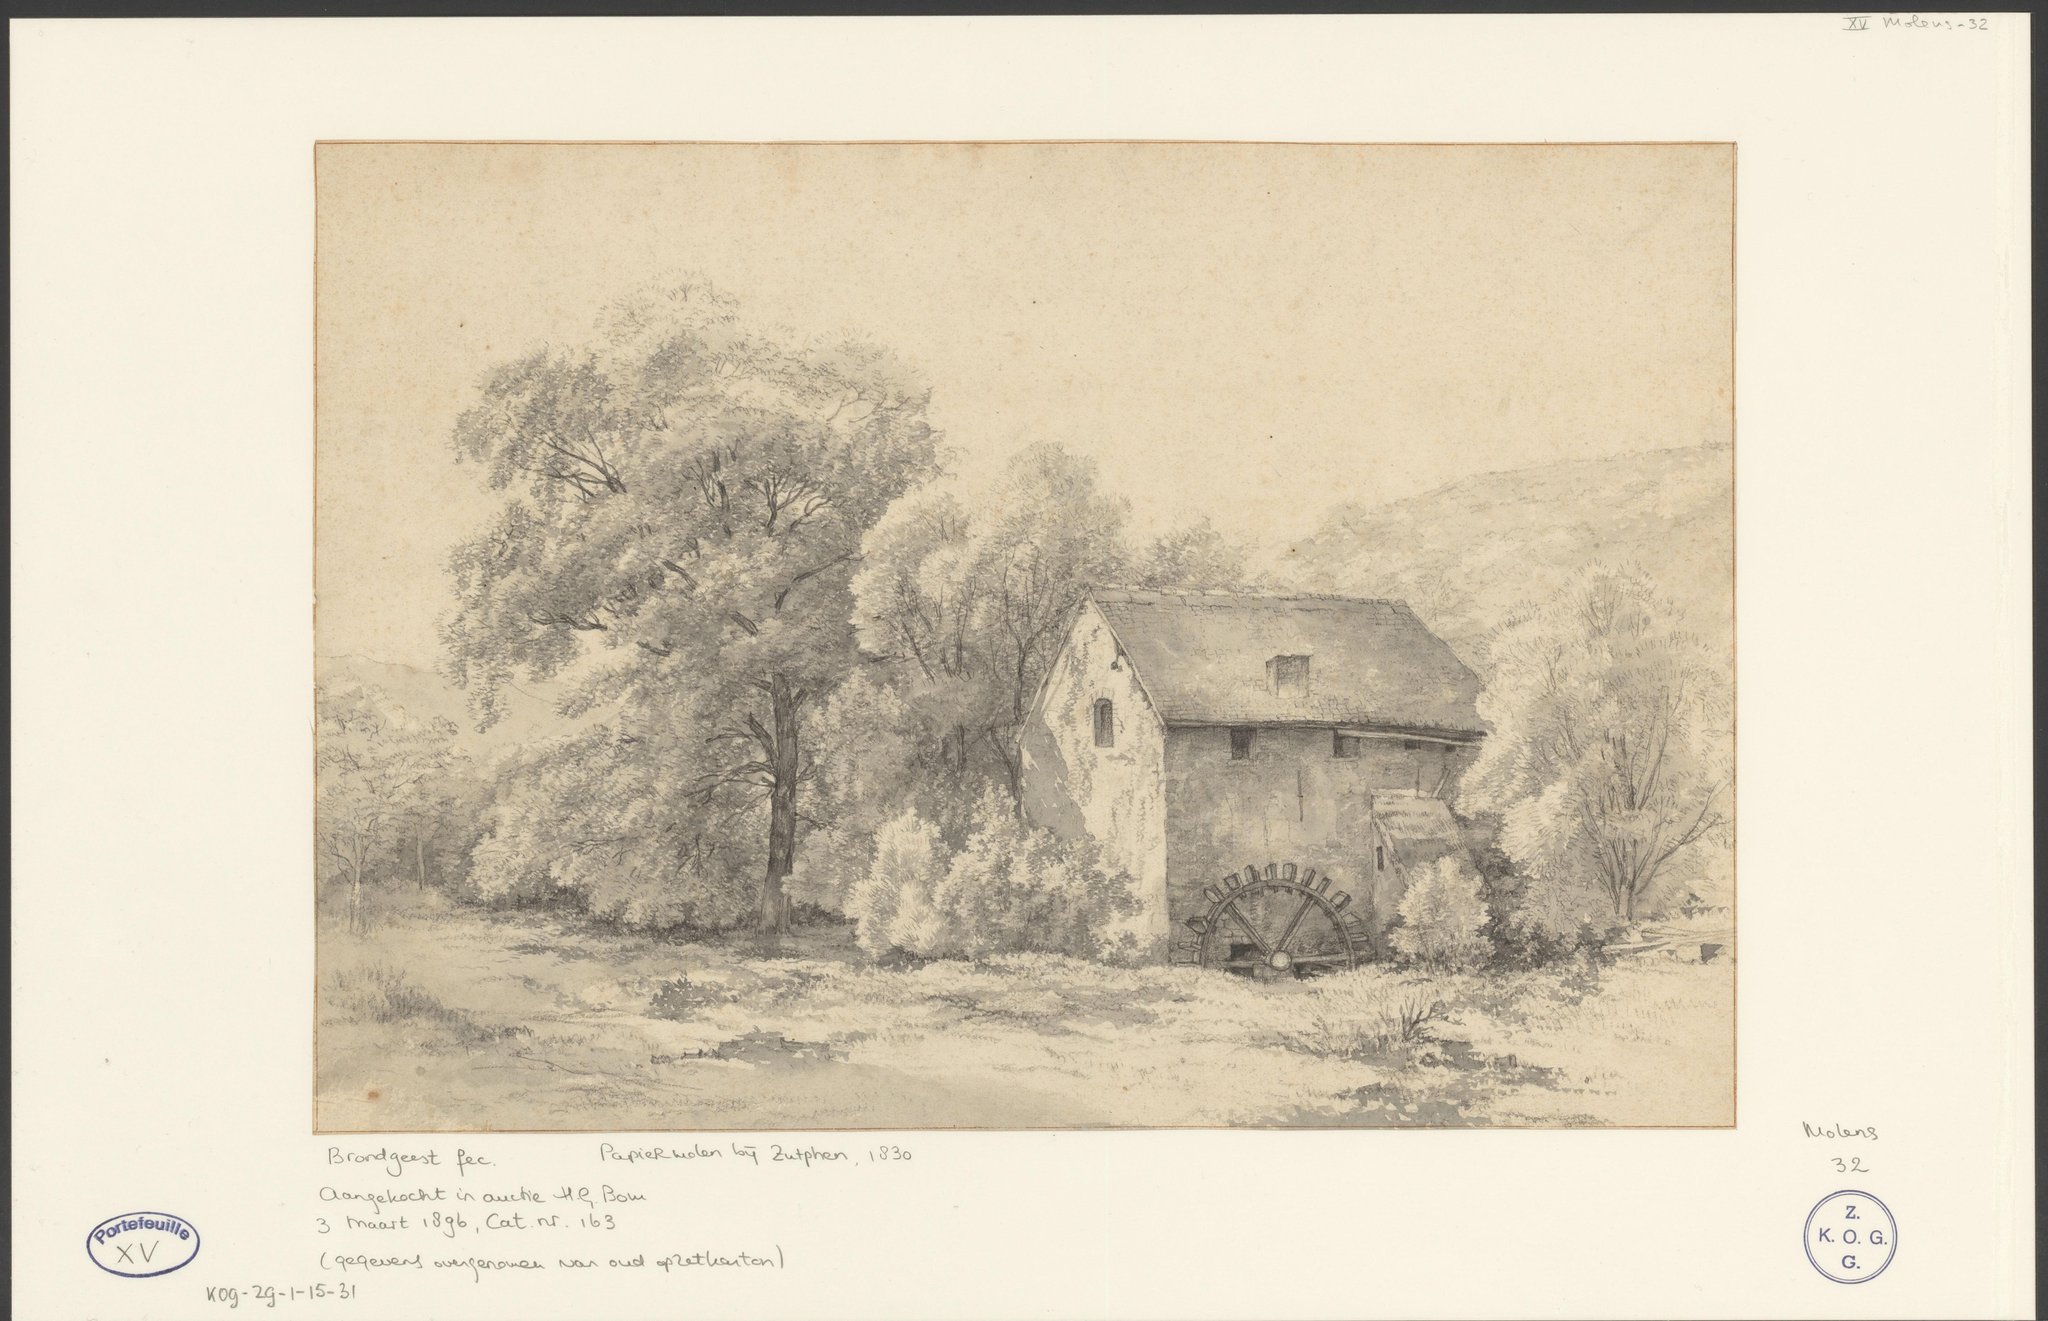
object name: drawing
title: Papiermolen bij Zutphen, 1830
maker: albertus brondgeest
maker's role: draughtsman, print maker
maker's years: 1786-1849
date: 1830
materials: chalk, ink, paper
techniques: brush, pen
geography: zutphen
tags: paper (writing material), watermill in landscape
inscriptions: stamp, collector's mark: Lugt 1641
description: Onderwerpsrubrieken binnen de Atlas Zeden en Gewoonten: Handel, nijverheid en verkeer, Molens.